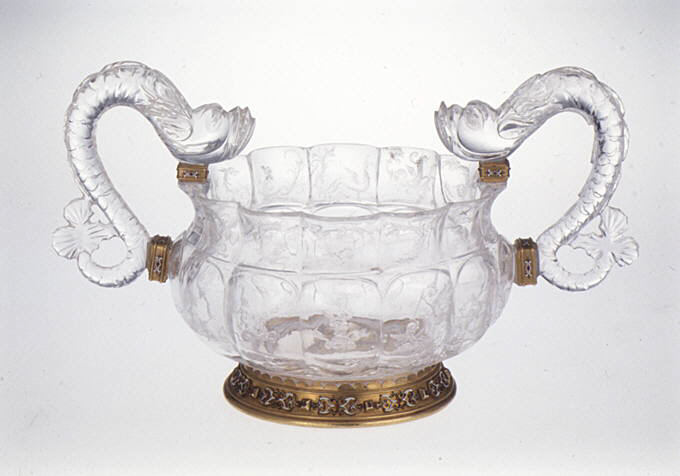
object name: bowl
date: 1601-1700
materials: quartz, gemstone, silver gilt